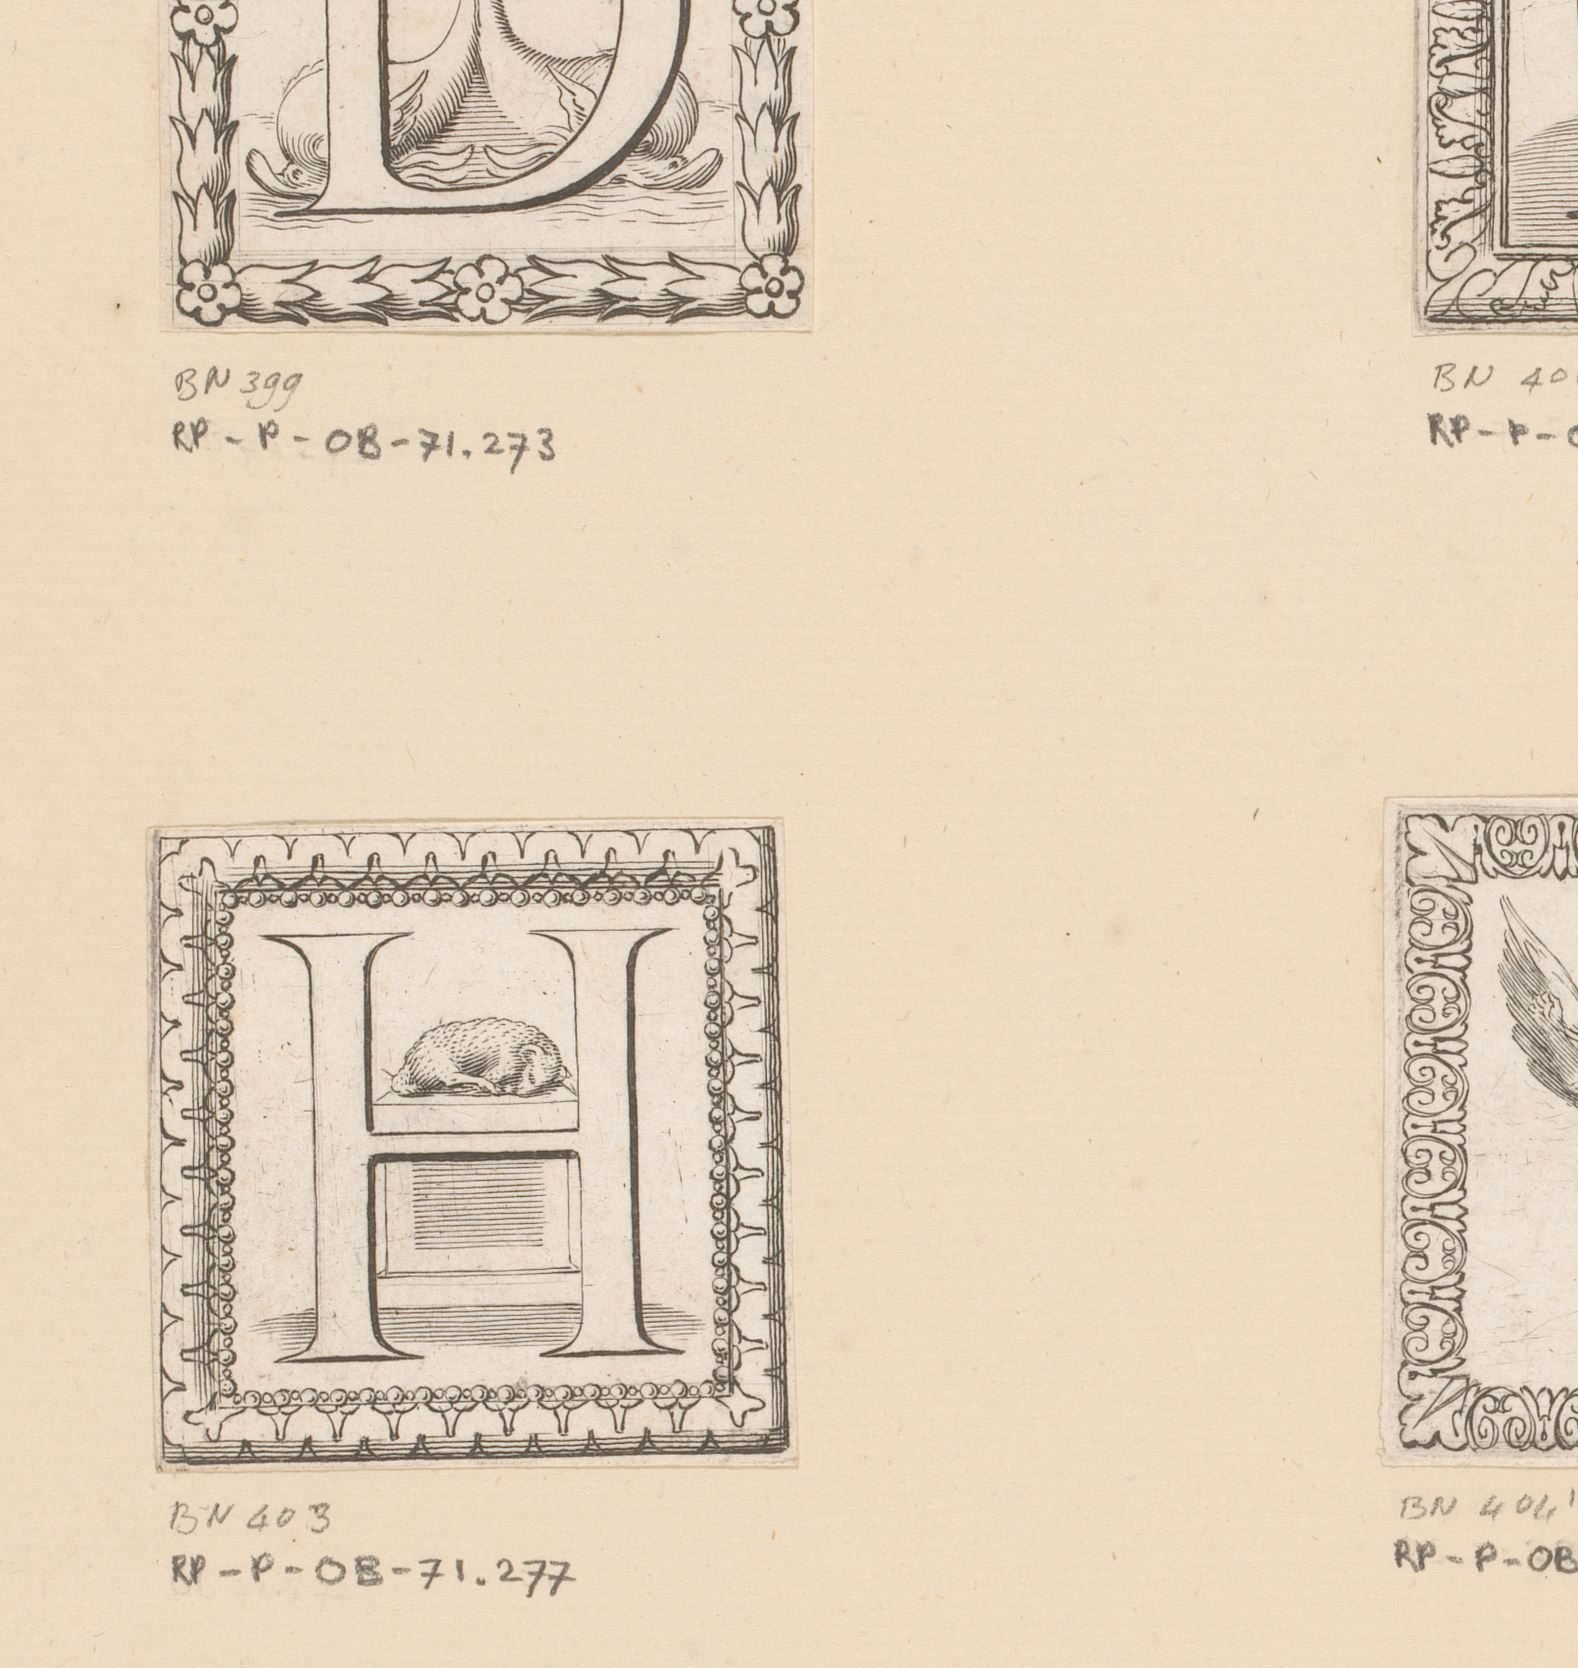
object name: print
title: Letter H met een lam op een altaar (hostia)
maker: claude mellan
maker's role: draughtsman, print maker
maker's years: 1598-1688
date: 1639-1643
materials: paper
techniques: engraving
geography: paris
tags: decoration of printed matter, letters, alphabet, script, lamb, altar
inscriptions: collector's mark: Lugt 240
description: Dit betreft één van de 21 letters die Mellan voor de Imprimerie Royale vervaardigde. Elke letter wordt vergezeld door een afbeelding van een onderwerp dat met dezelfde letter begint. Tussen 1639-1643 werkte Mellan samen met de Imprimerie Royale (IFF 17e siècle, p. 21-22). Hij vervaardigde verschillende vignetten, letters, culs-de-lampe en decoratieve banden (IFF 17e siècle, p. 215-220). O.a. gebruikt voor de publicatie: Vergilius Maro, Publius. Publii Virgilii Maronis Opera. Parijs: Imprimerie Royale, 1641. Zie IFF 17e siècle, p. 219, nr. 403.